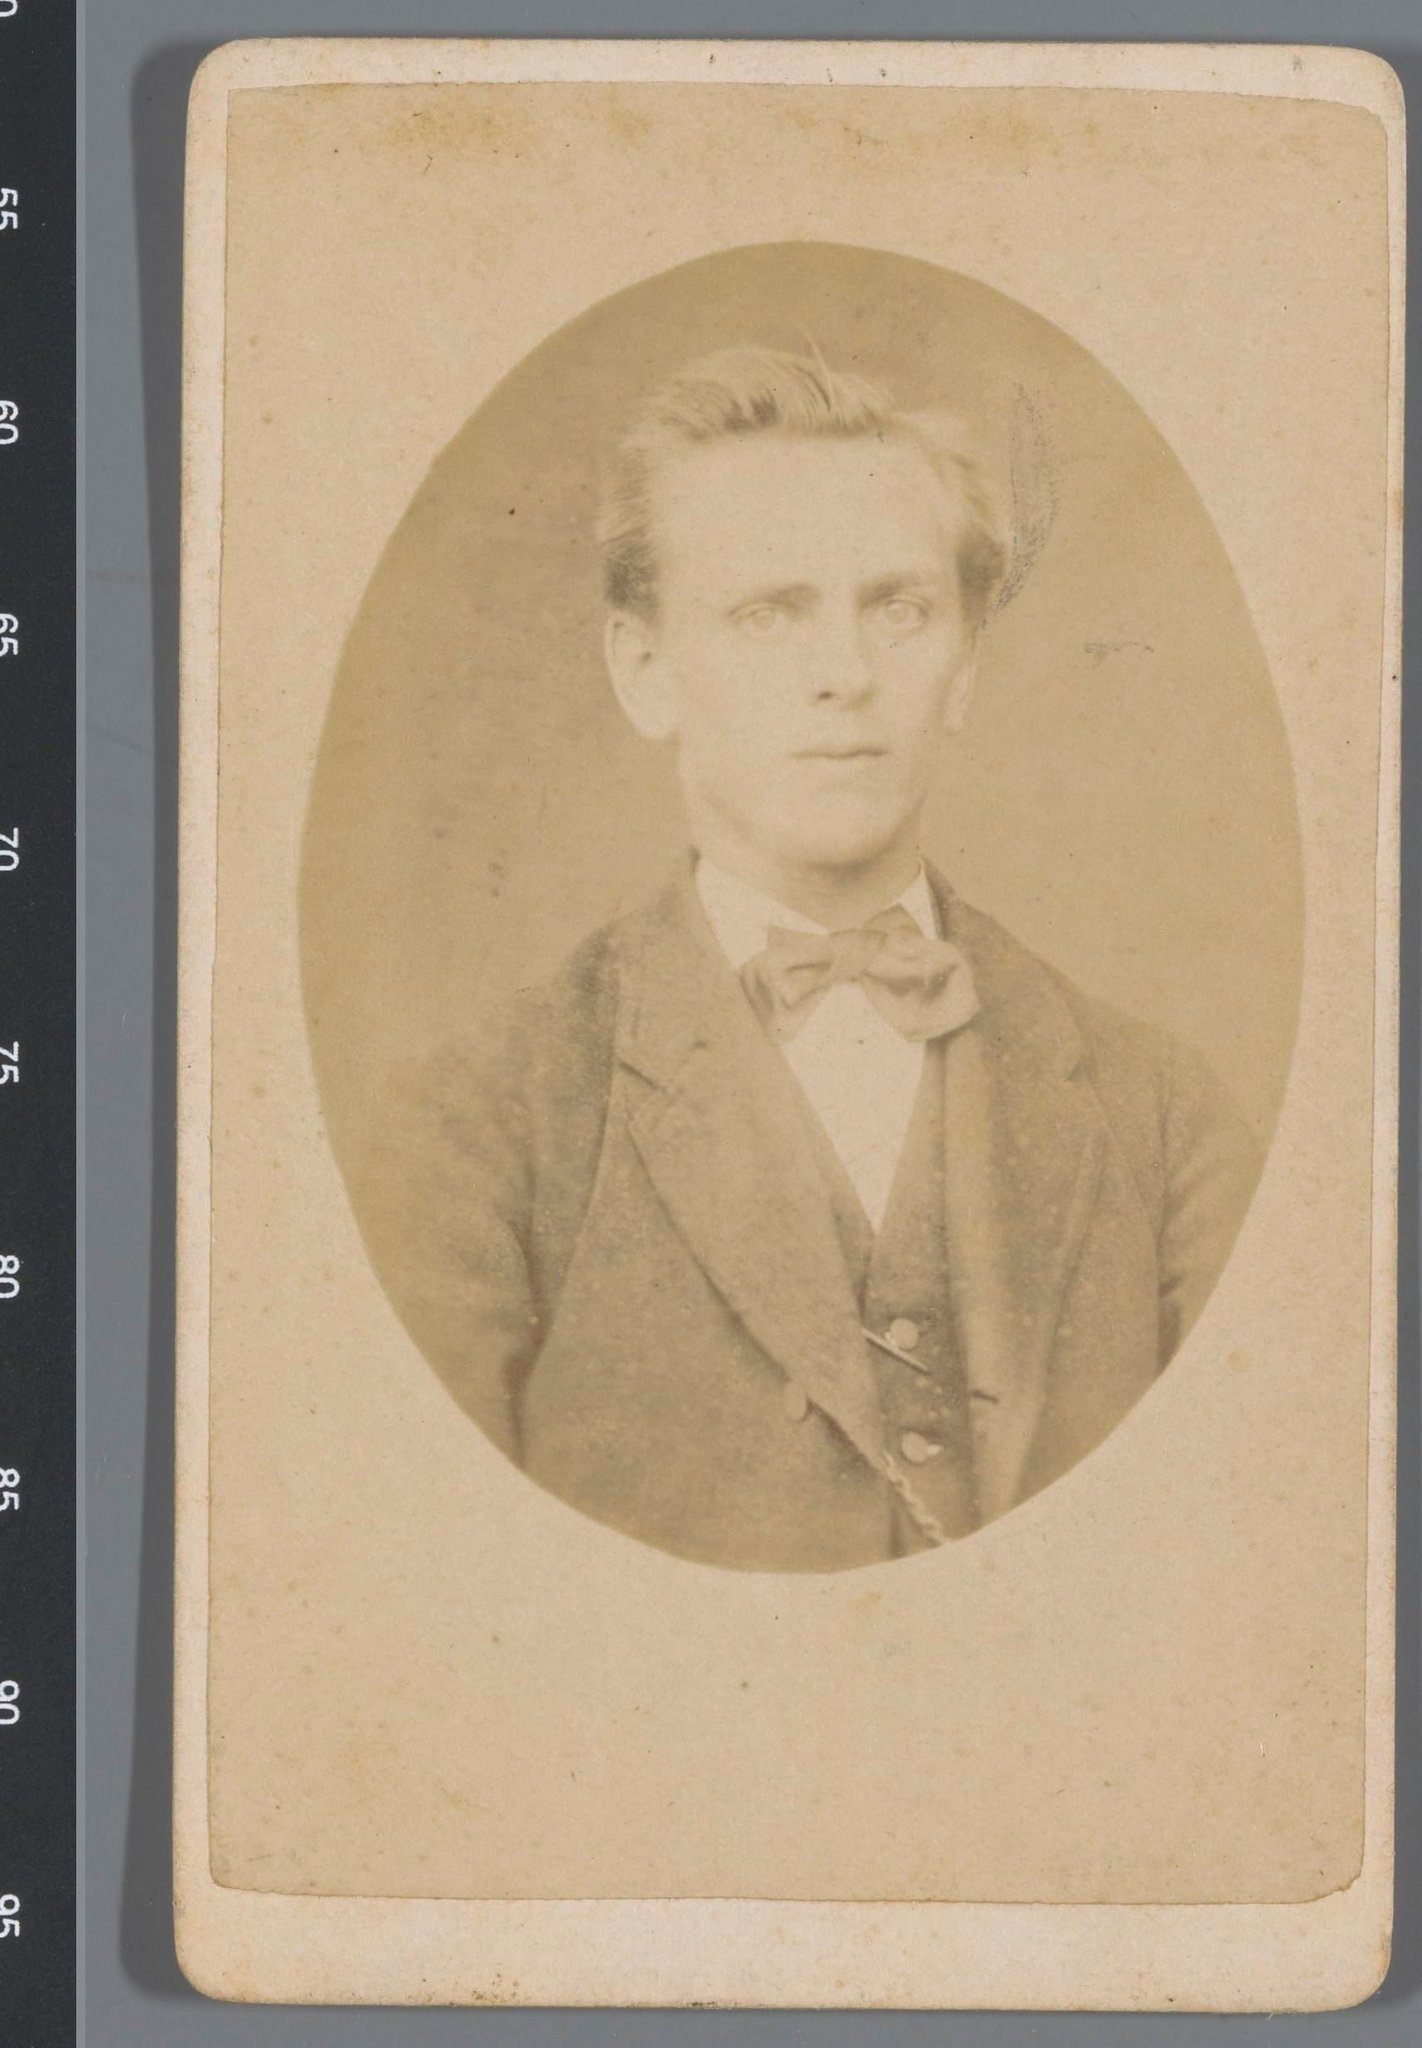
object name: carte de visite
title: Portret van Dirk de Groot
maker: henri paul emile de la roche busé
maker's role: fotograaf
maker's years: 1857-1940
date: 1885-1919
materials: cardboard, paper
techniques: albumen print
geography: leeuwarden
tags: historical persons, youth, adolescent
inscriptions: inscription: ‘Photogr. Etablissementen/ van/ H.P.E. de la Roche Busé/ te/ Leeuwarden/ en/ Bolsward./ Zoowel des winters als des zomers zijn bij/ alle weersgesteldheid de ateliers geopend/ van 9 tot 4 uur.’, inscription: ‘Dirk de Groot’